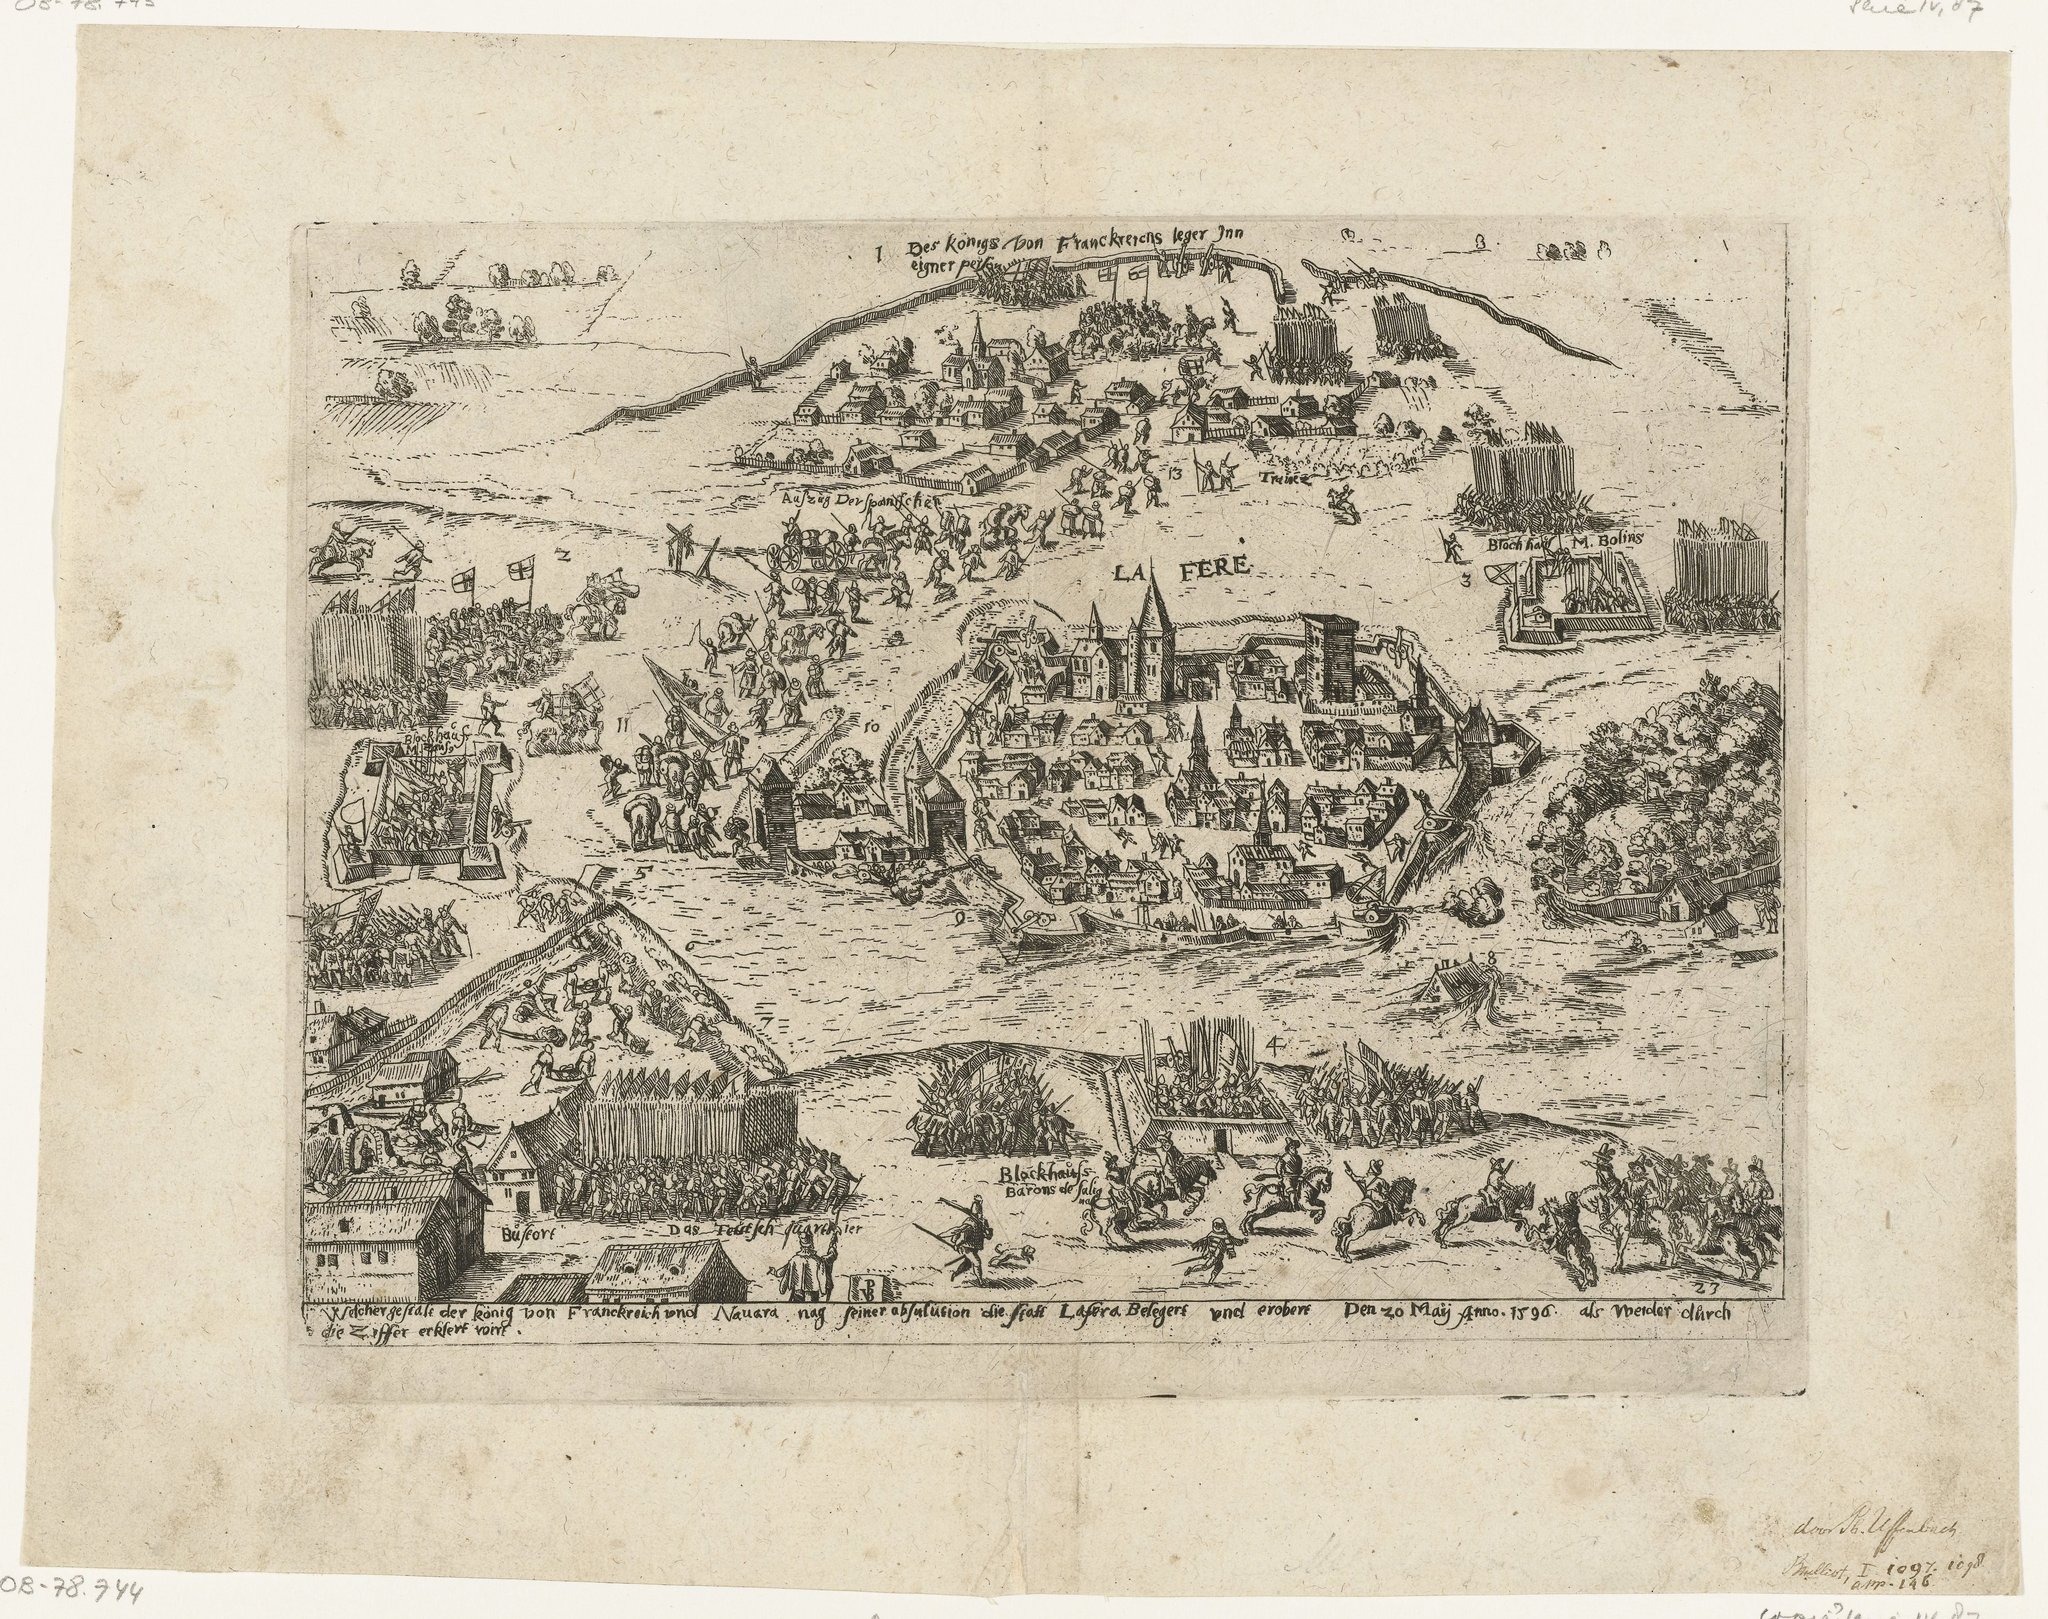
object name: print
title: Hendrik IV neemt La Fère in, 1596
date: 1596-1598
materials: paper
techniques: etching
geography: germany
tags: paris, hendrik iv (koning van frankrijk en navarra), capture of city (after the siege)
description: Troepen van koning Hendrik IV veroveren La Fère op de Spanjaarden, 20 mei 1596. Met onderschrift van 2 regels in het Duits. Ongenummerd. Kopie naar de prent van Hogenberg.